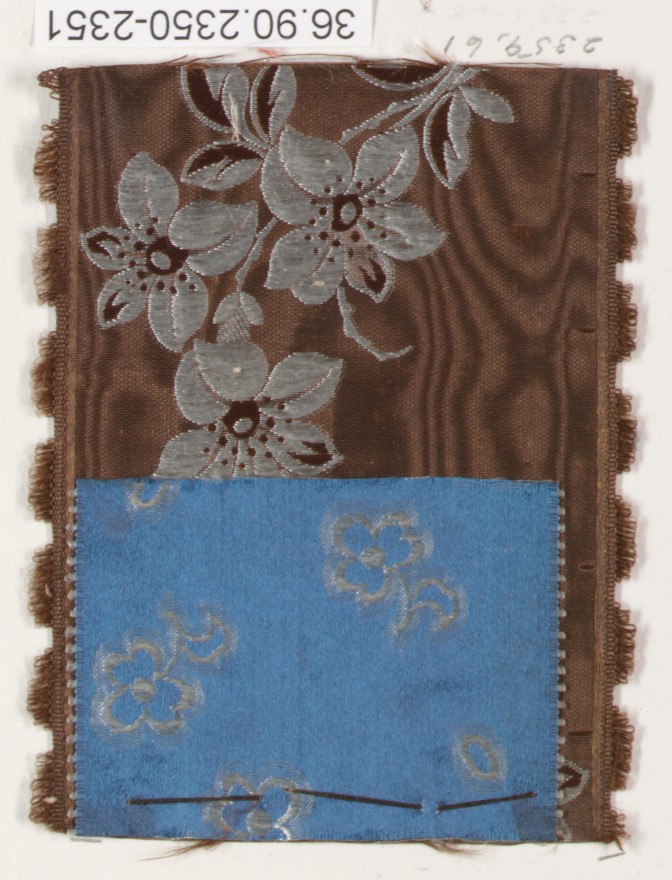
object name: ribbon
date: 1801-1900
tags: flowers